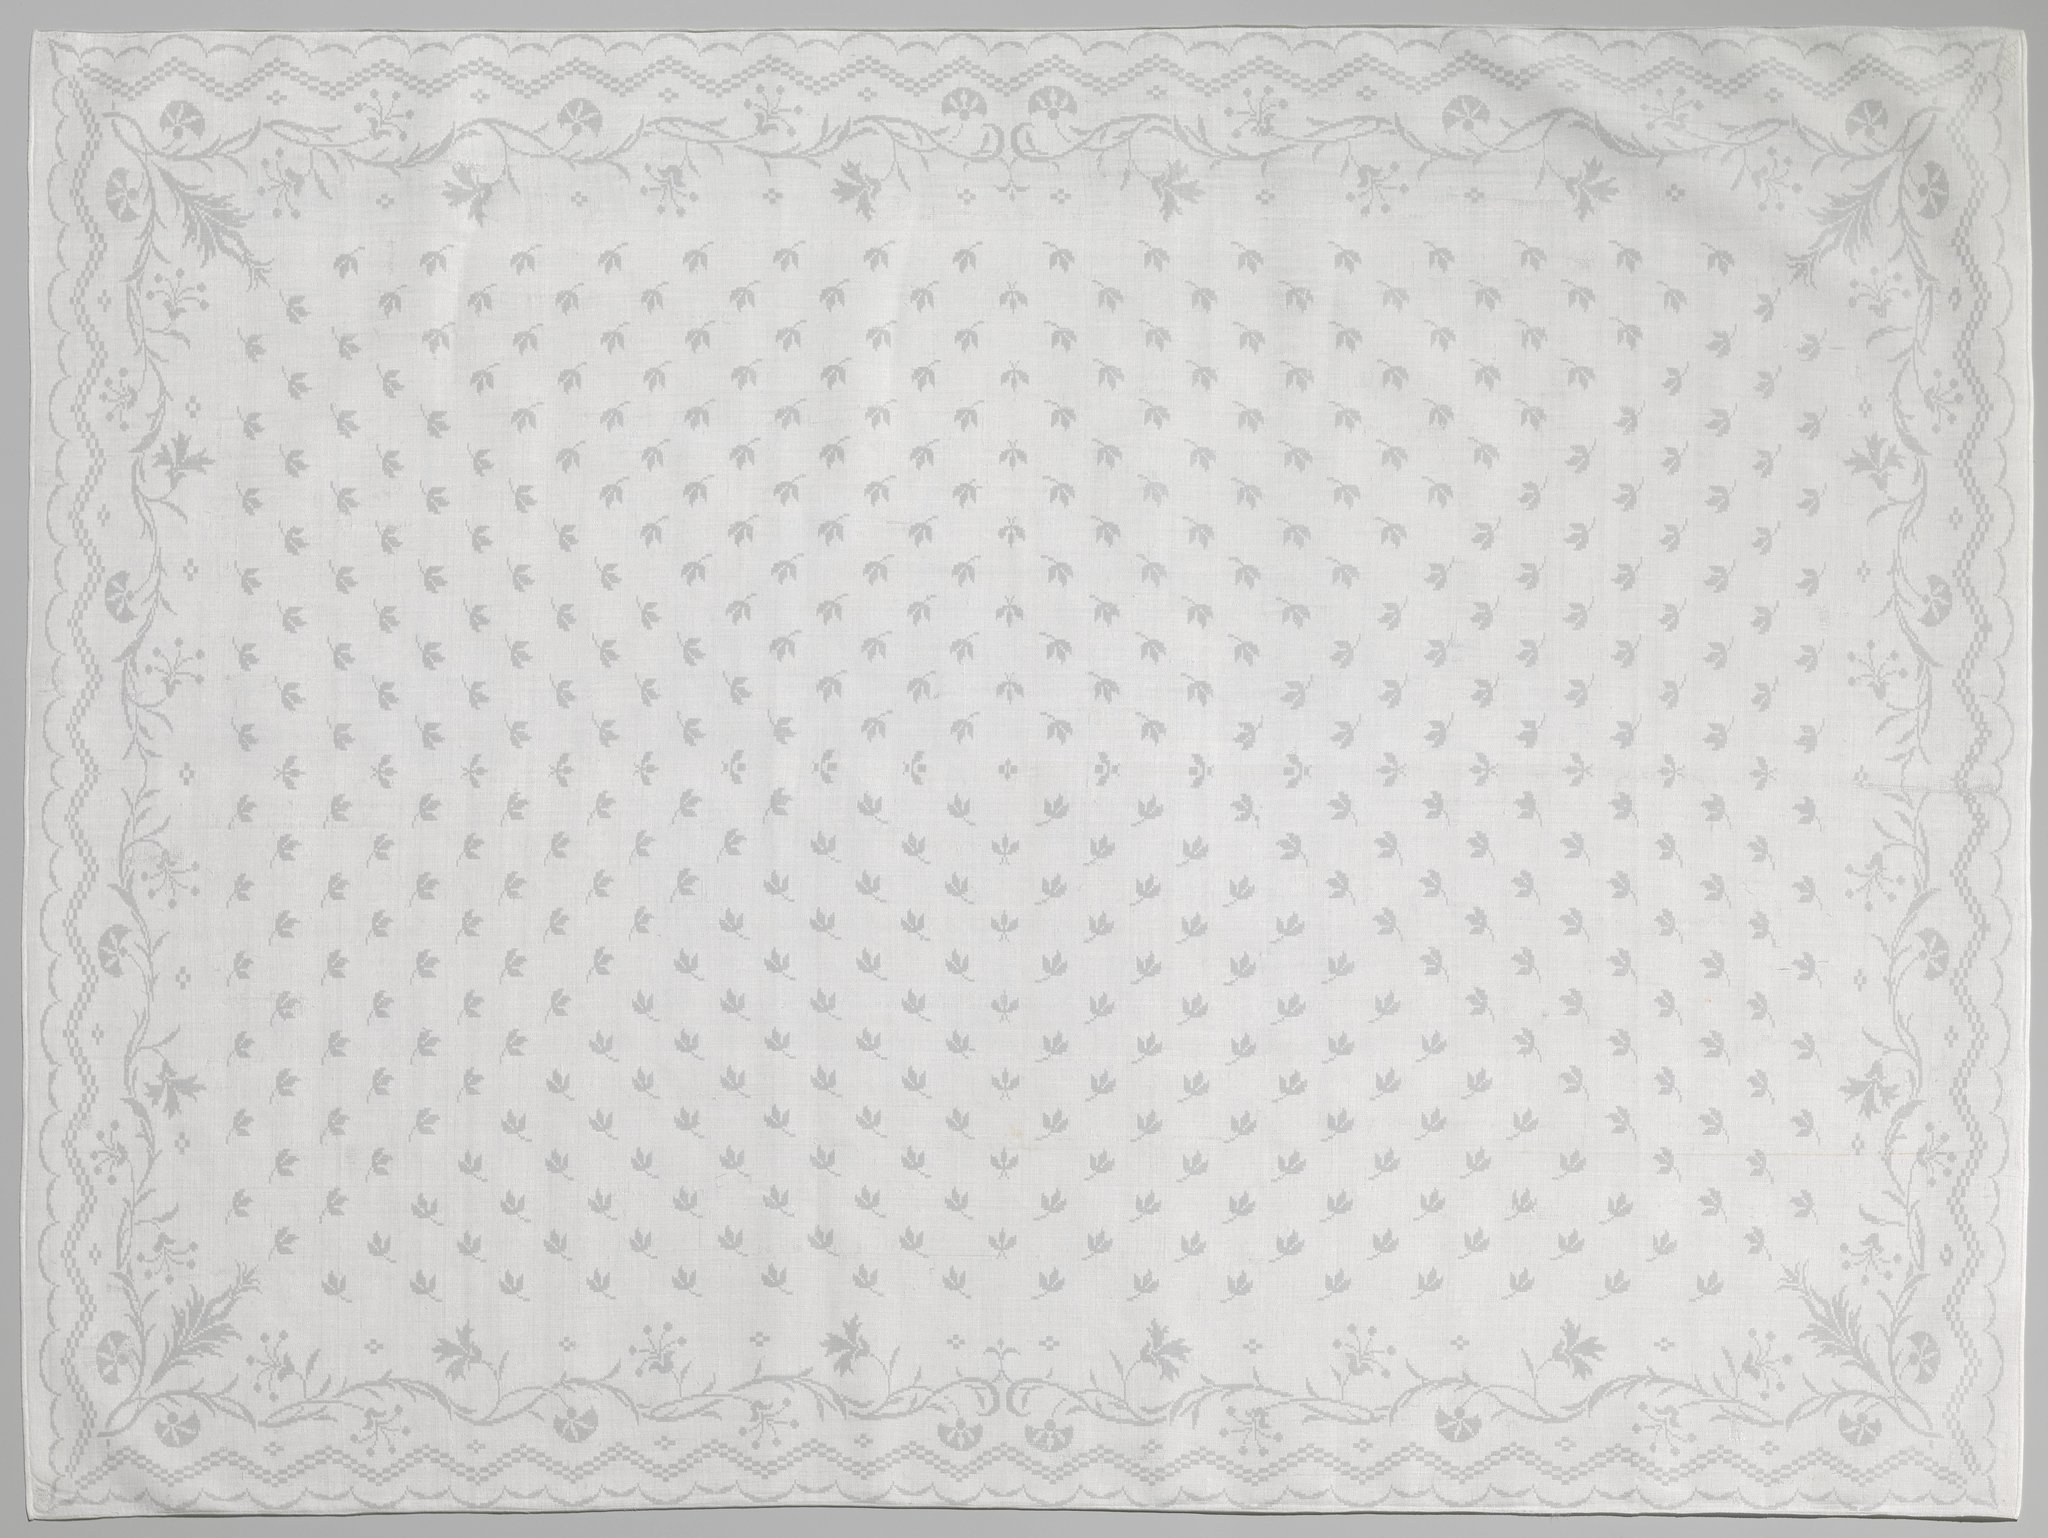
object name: napkin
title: Servet met gestrooid blad en rand met anjers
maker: Anonymous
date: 1767-1816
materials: linen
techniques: damask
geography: germany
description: Wit linnendamasten servet met patroon van gestrooide blaadjes en rand met anjers, merk WS 30.